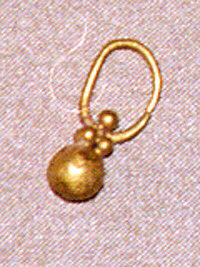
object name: earring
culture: alanic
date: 601-900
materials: gold, metal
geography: caucasus